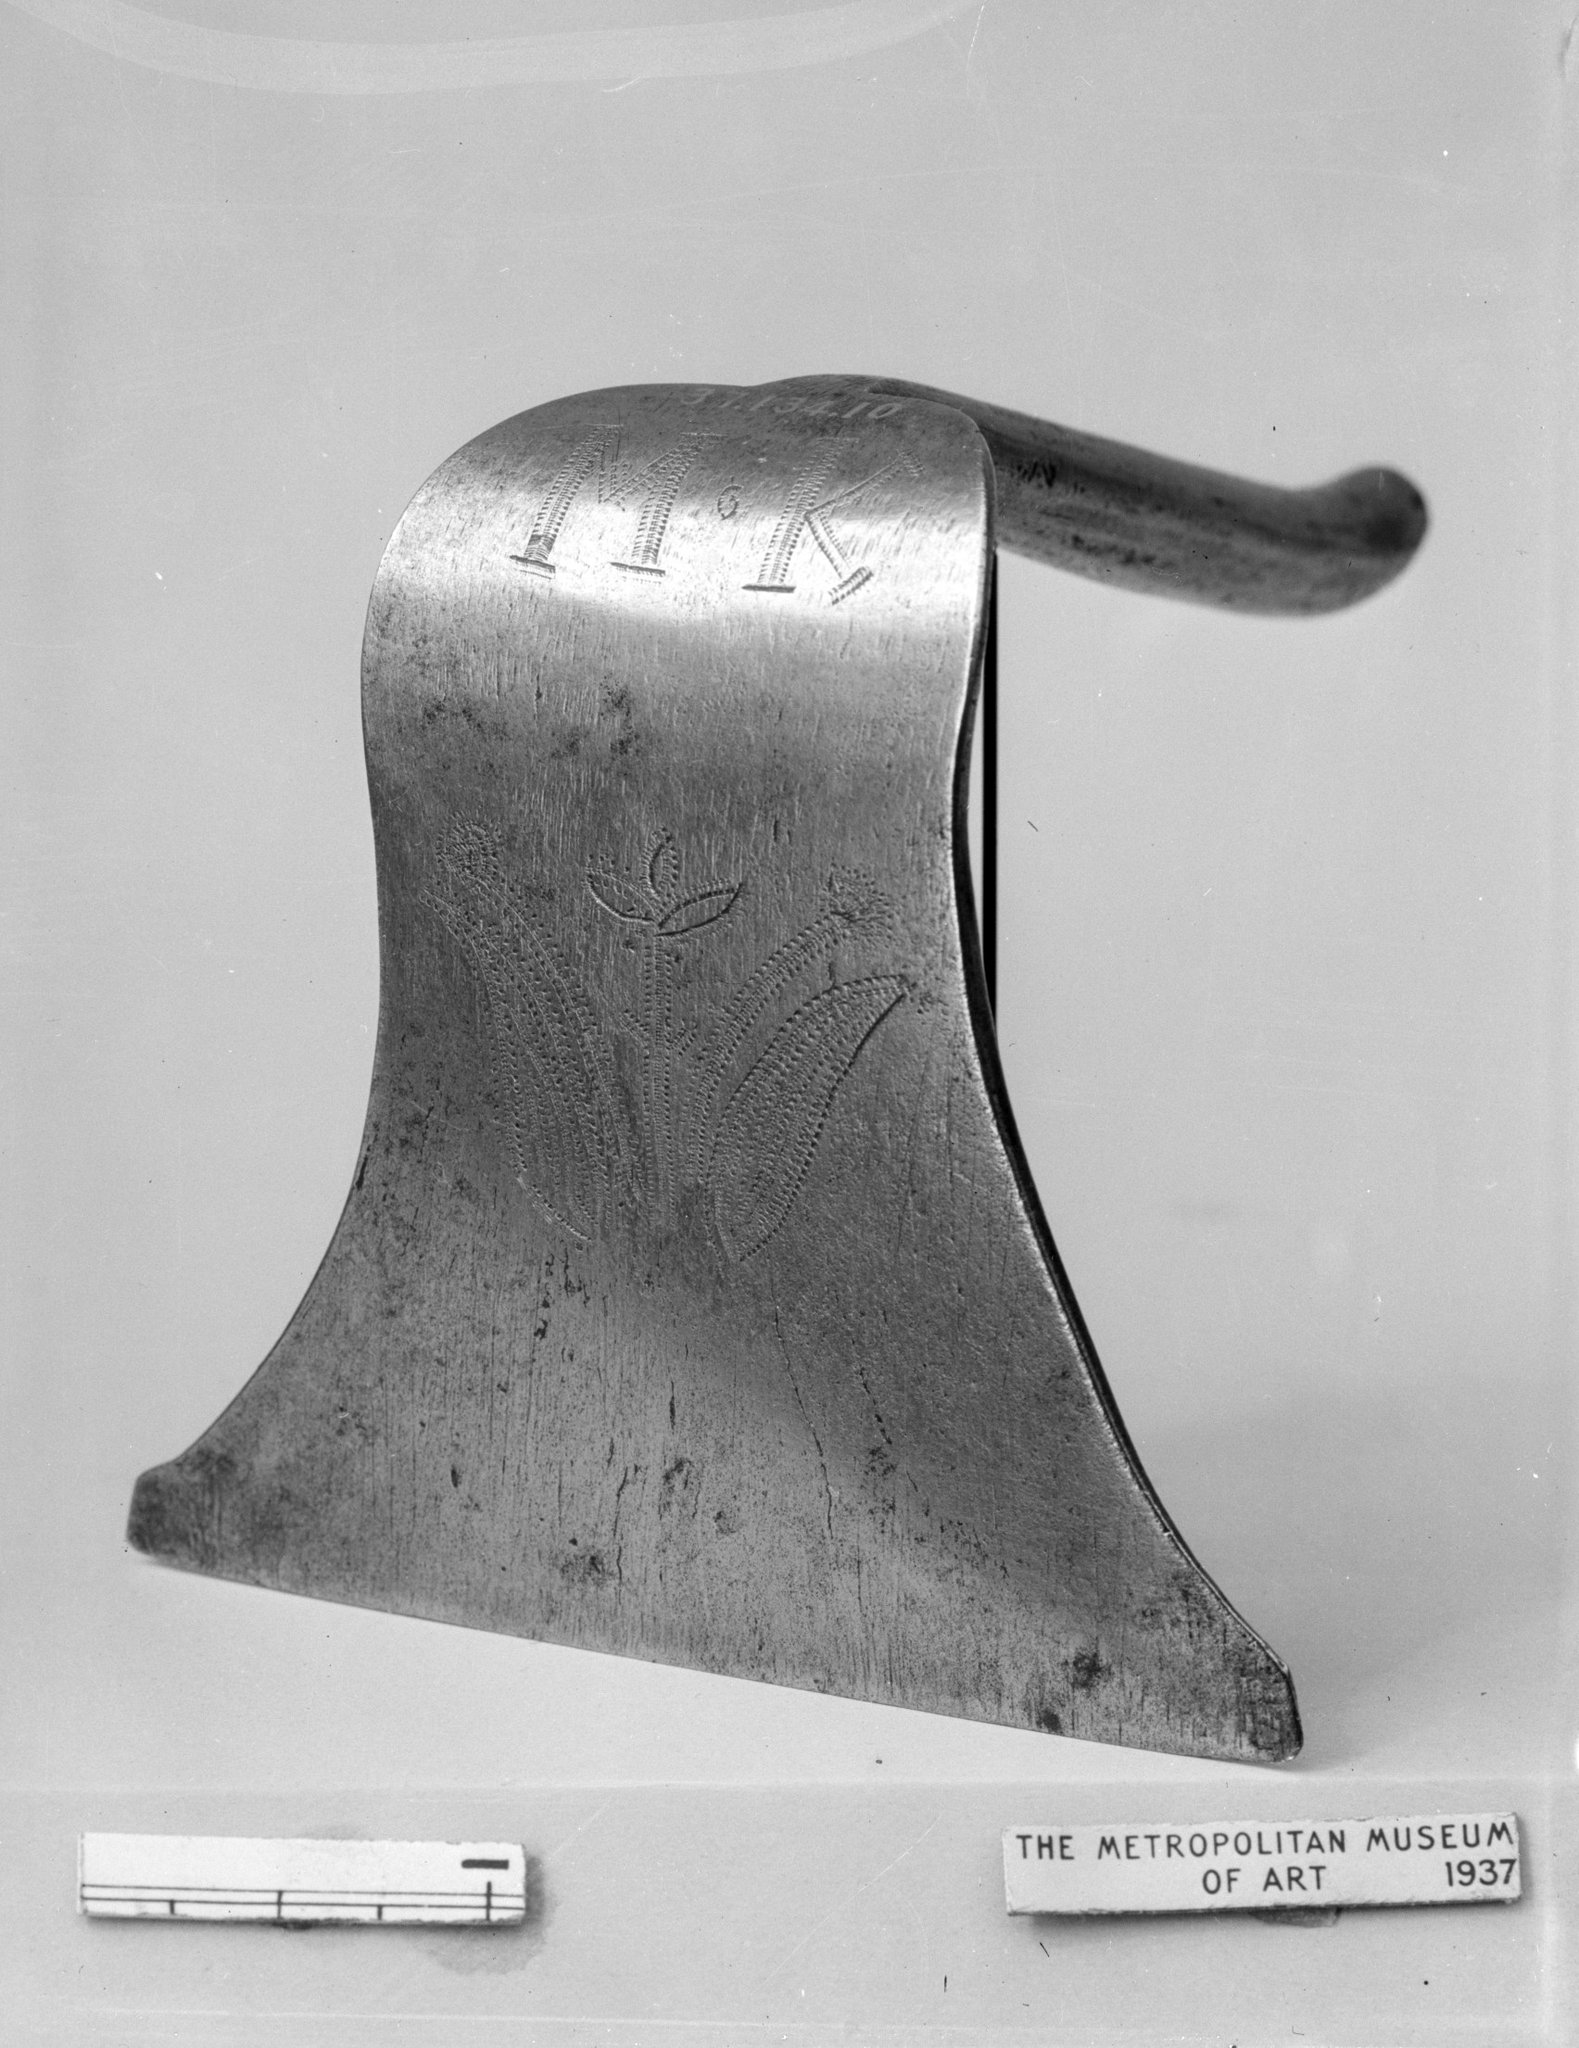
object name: dough board scraper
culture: american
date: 1800-1830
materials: iron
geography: united states